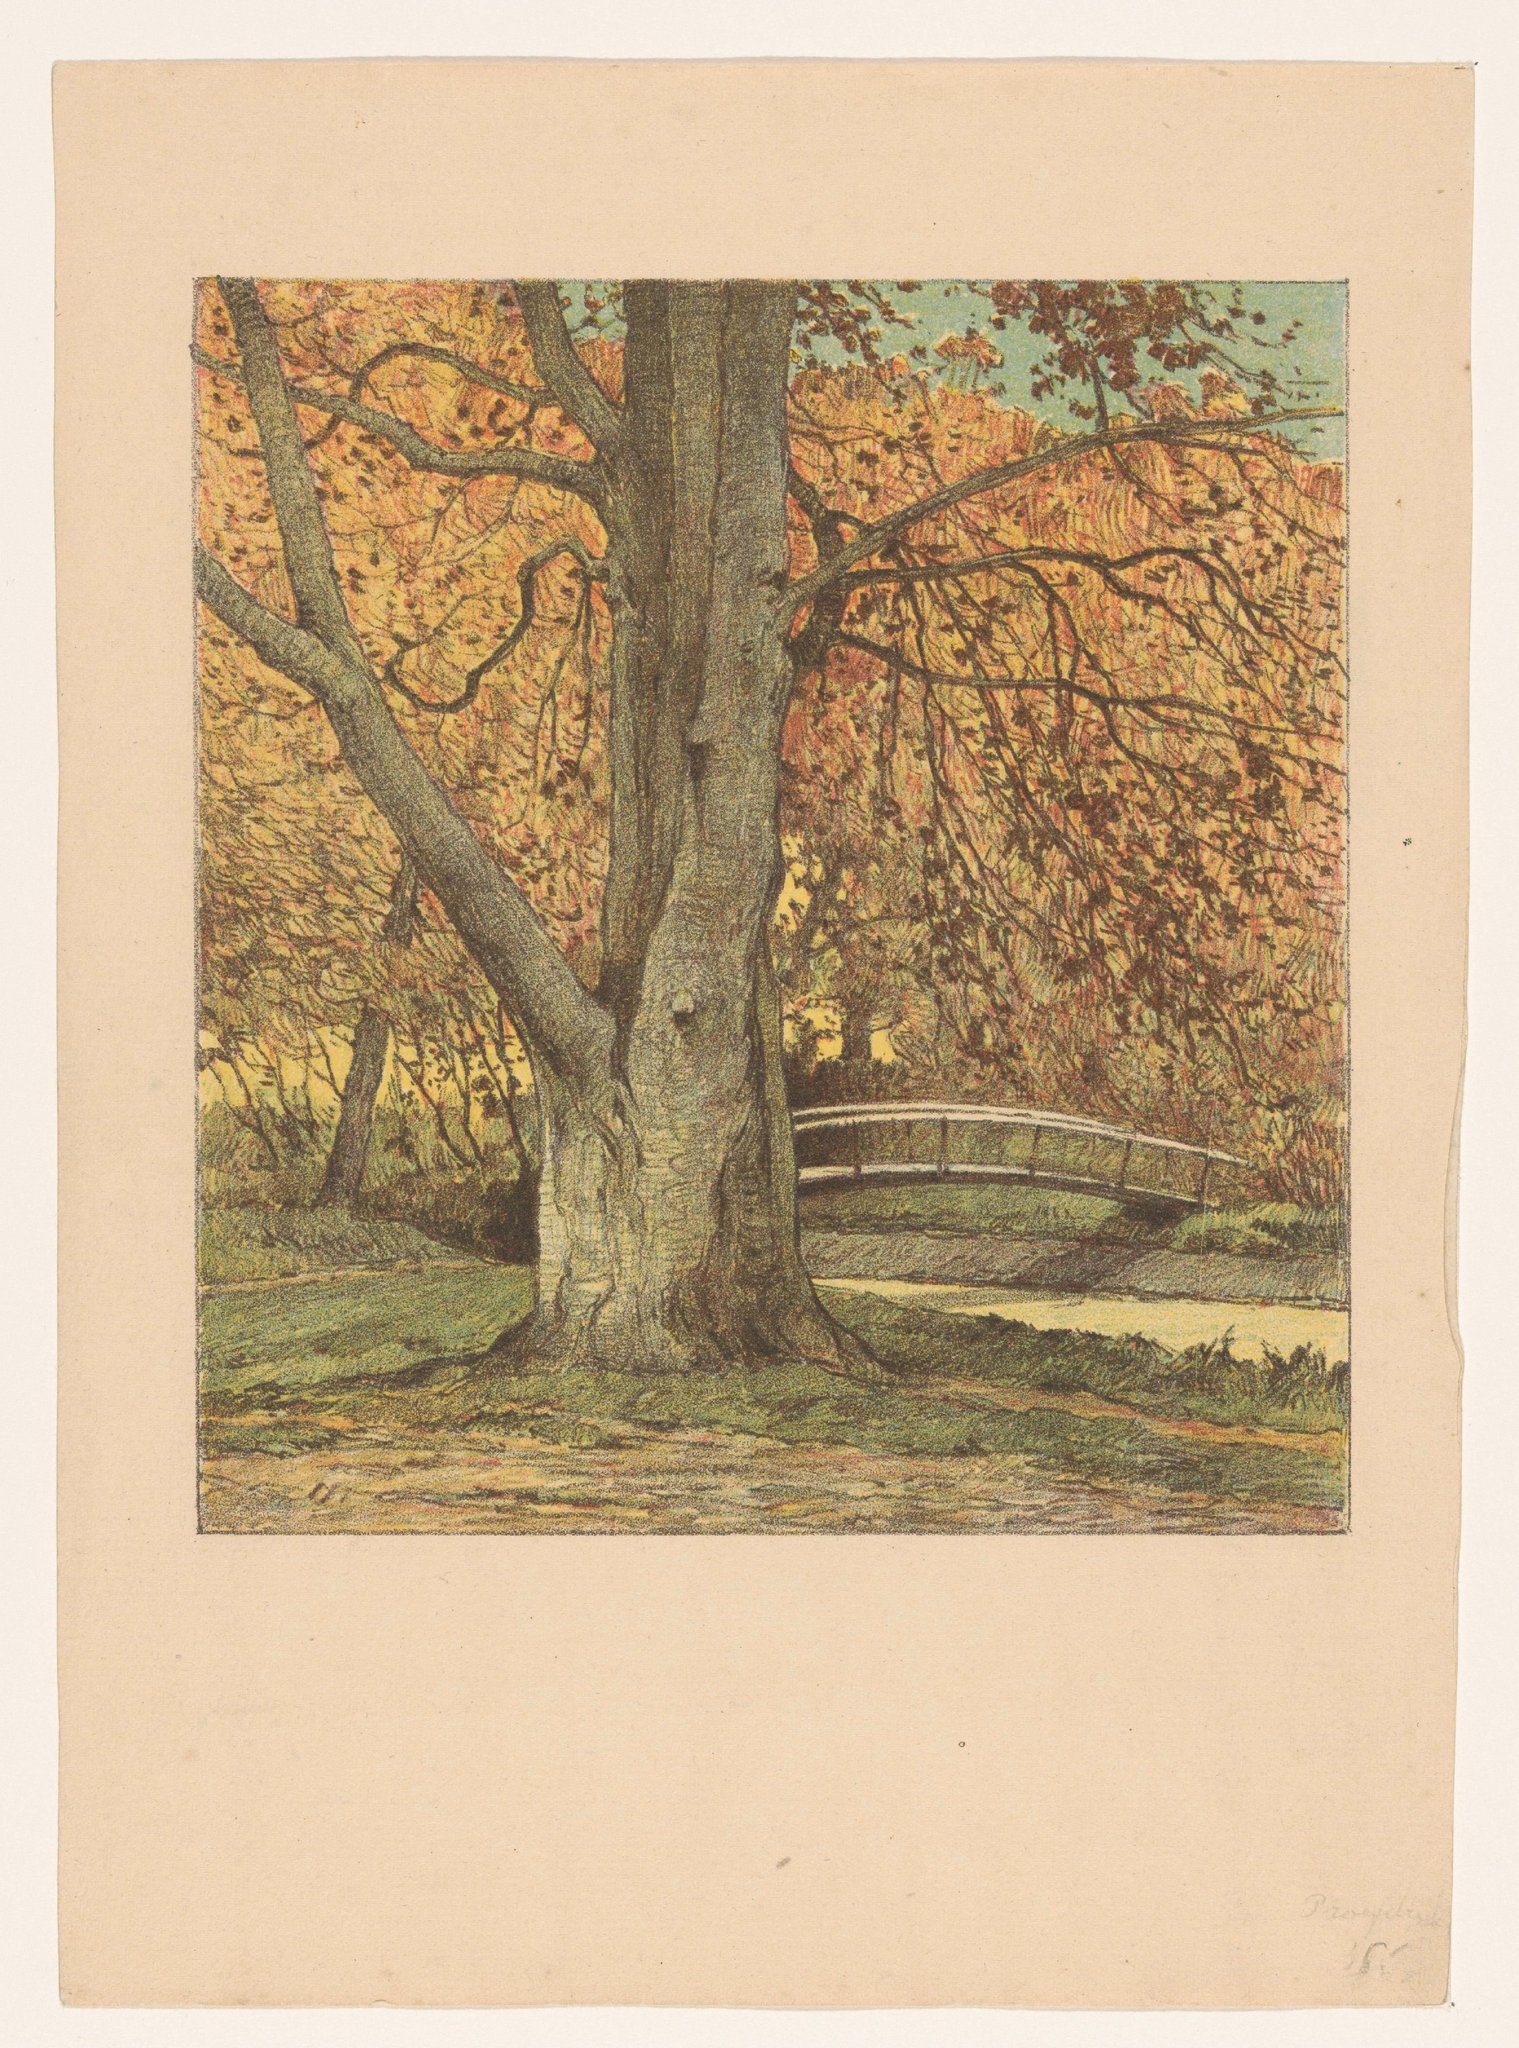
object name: print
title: Boom bij beek in de herfst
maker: simon moulijn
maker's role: draughtsman, print maker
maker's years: 1866-1948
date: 1876-1948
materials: paper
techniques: lithograph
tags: trees, brook, autumn landscape; landscape symbolizing autumn (the four seasons of the year)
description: Op de achtergrond een brug over de beek.